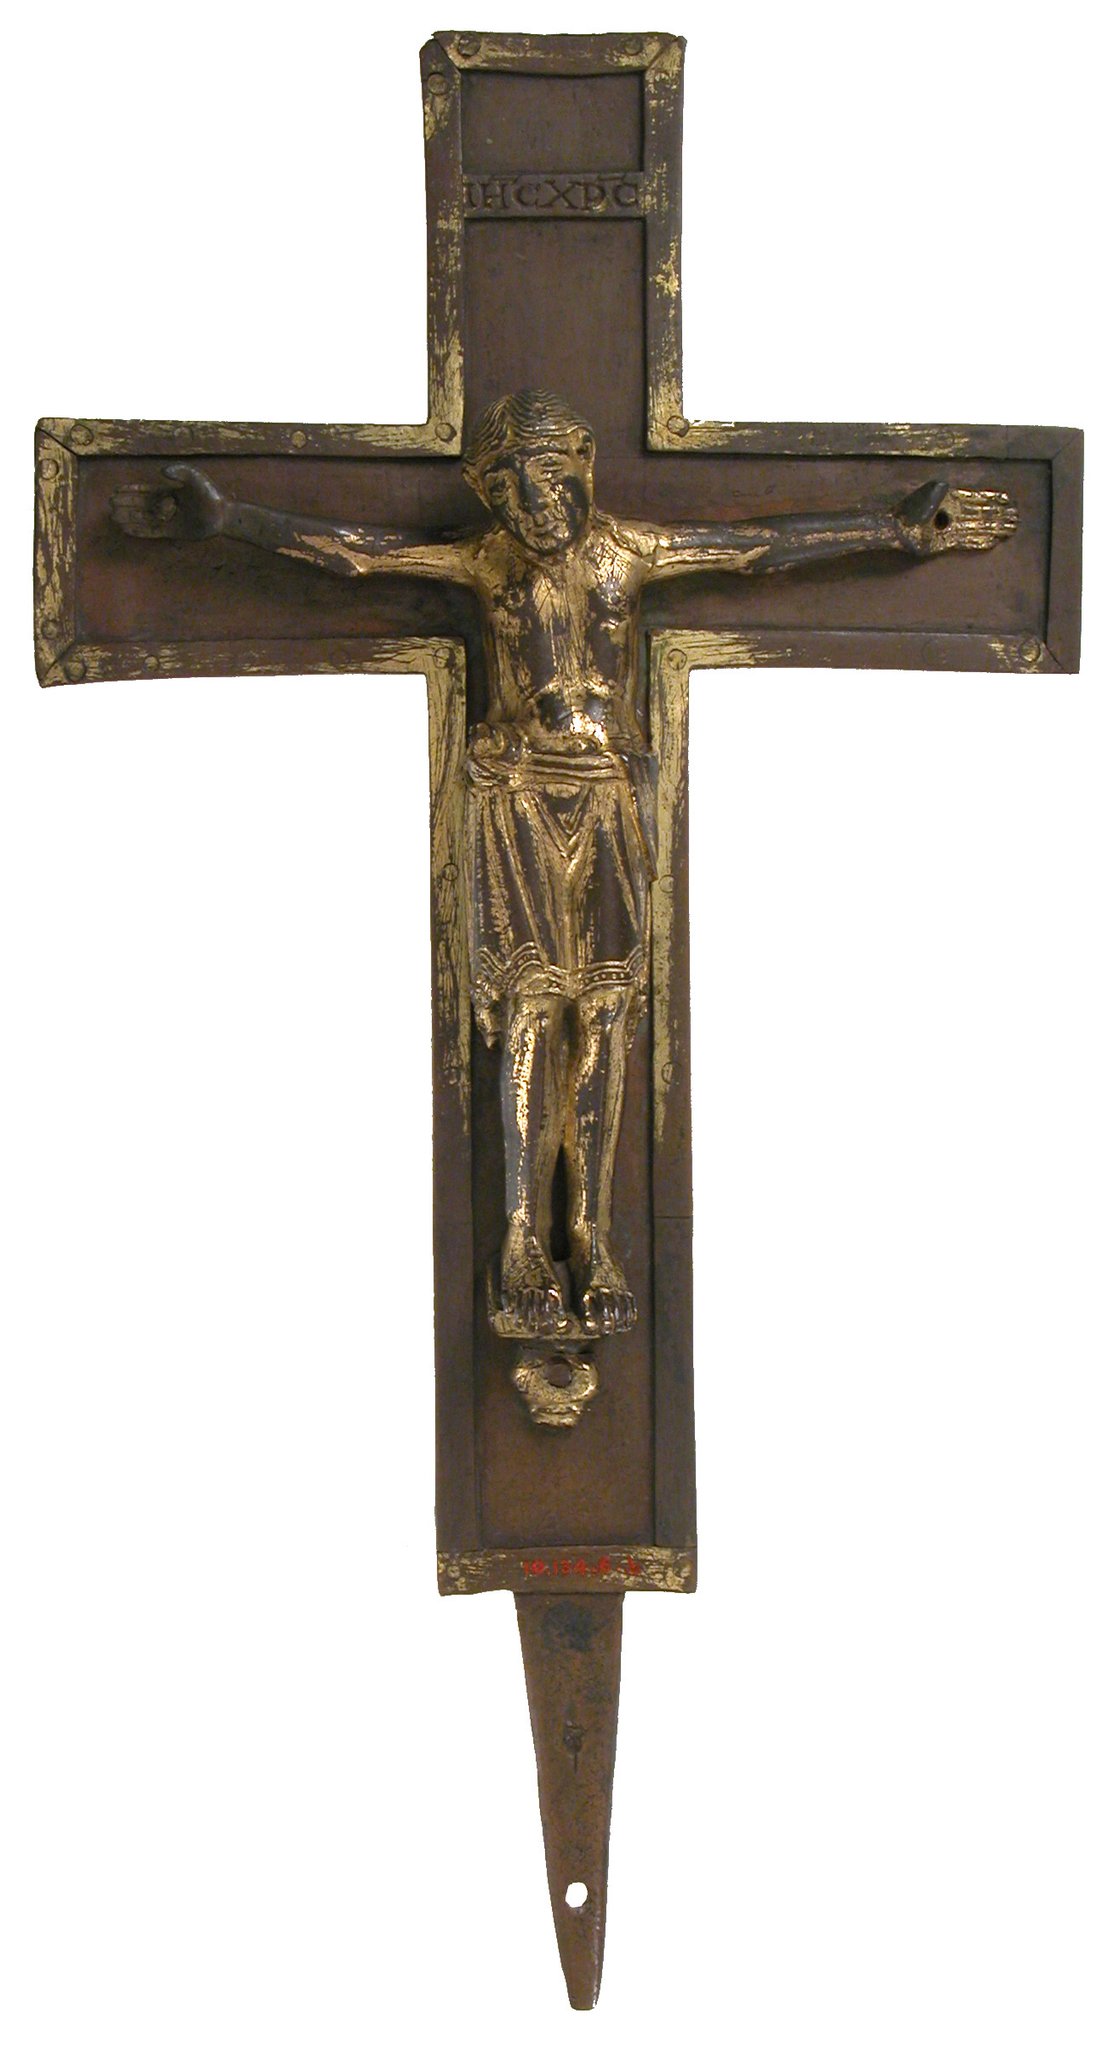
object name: crucifix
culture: german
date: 1125-1150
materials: copper alloy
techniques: gilding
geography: germany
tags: christ,cross